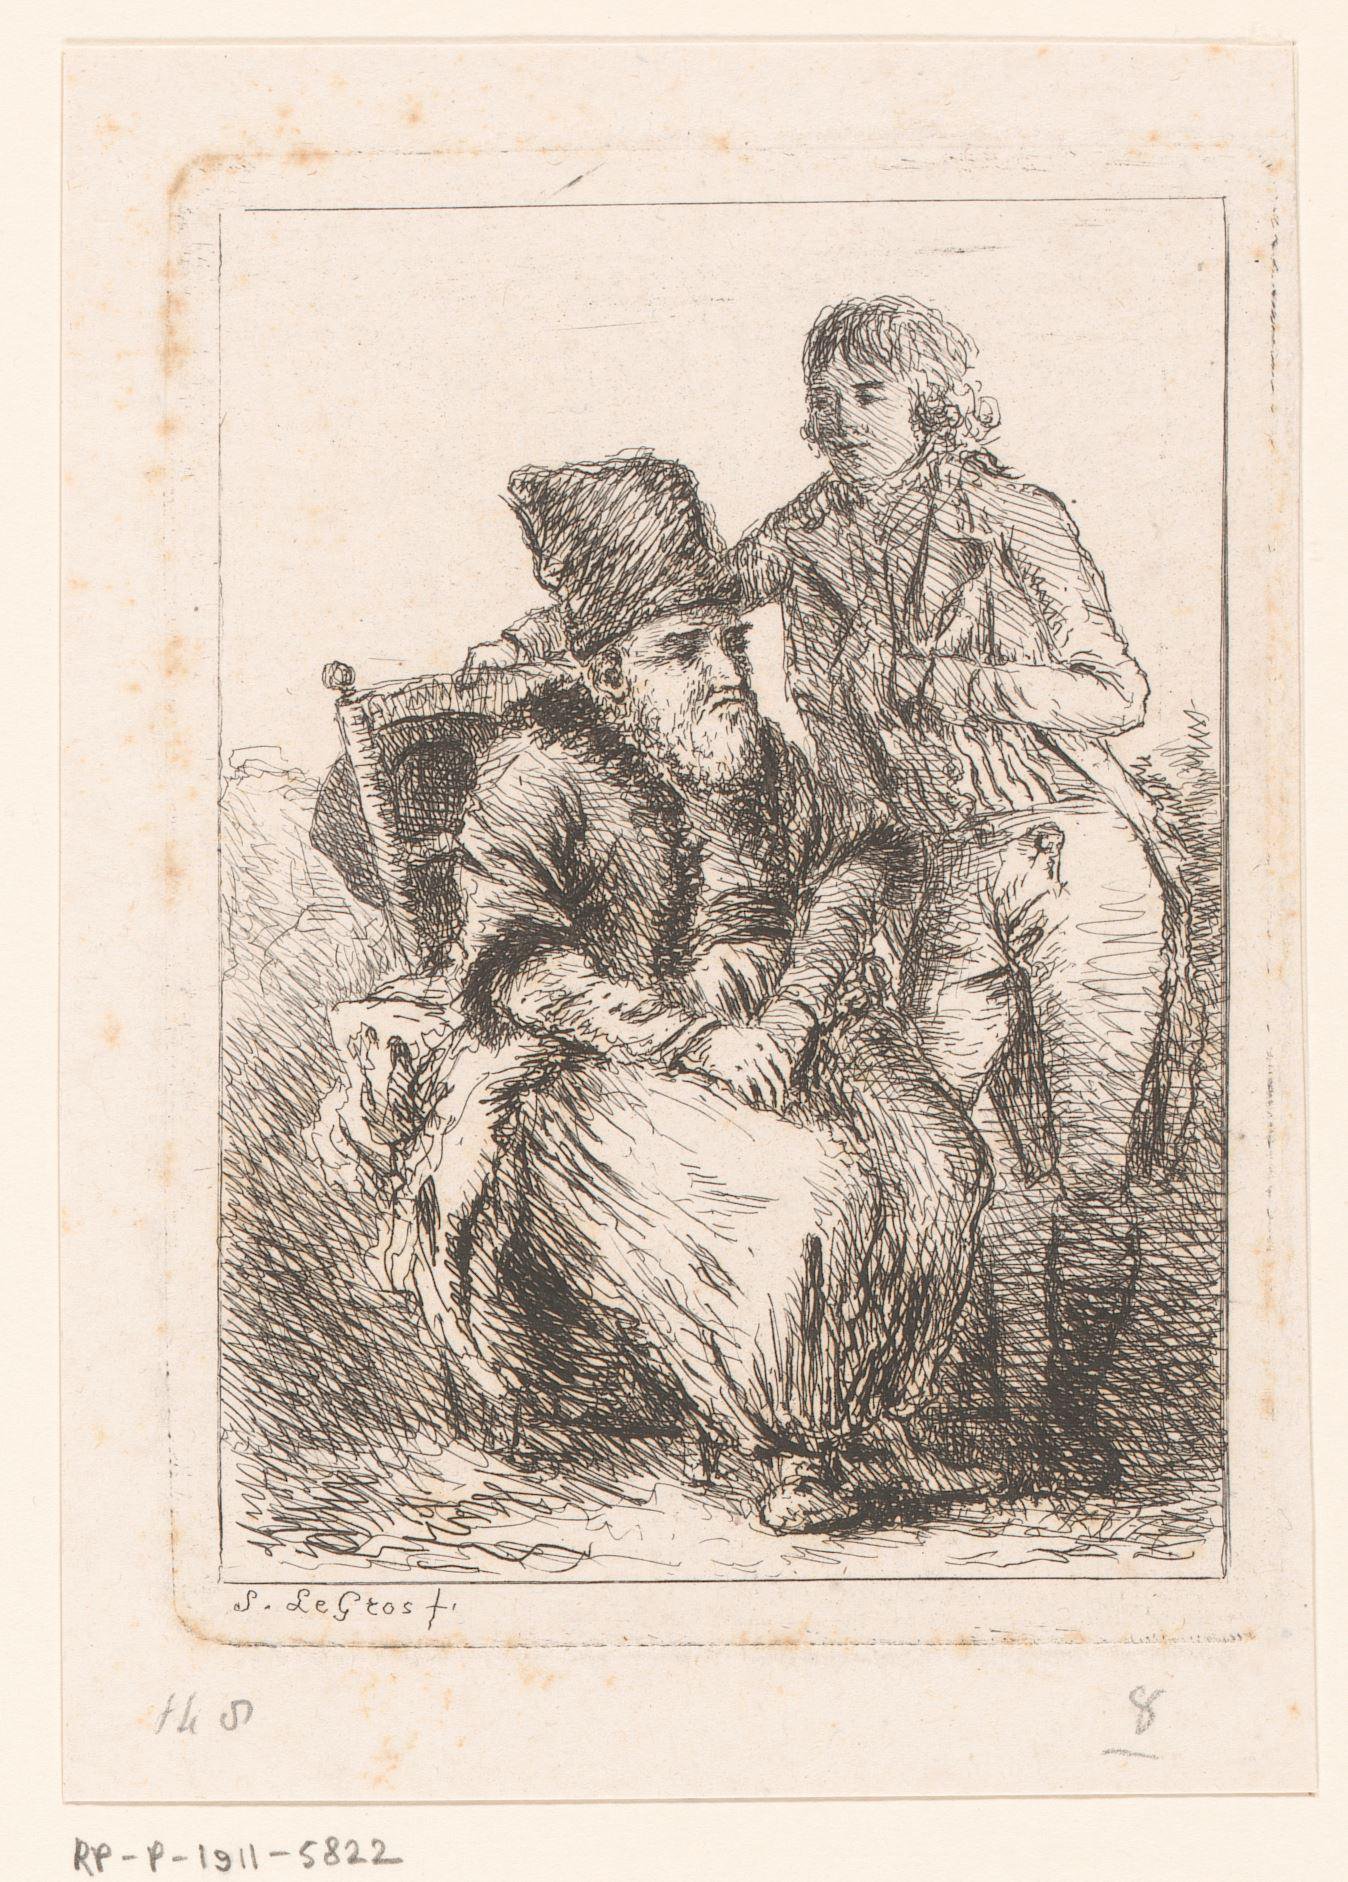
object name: print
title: Portret van Émile Le Gros en Soliman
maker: sauveur legros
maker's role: print maker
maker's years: 1754-1834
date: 1764-1834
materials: paper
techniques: etching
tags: historical persons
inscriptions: collector's mark: Lugt 2228